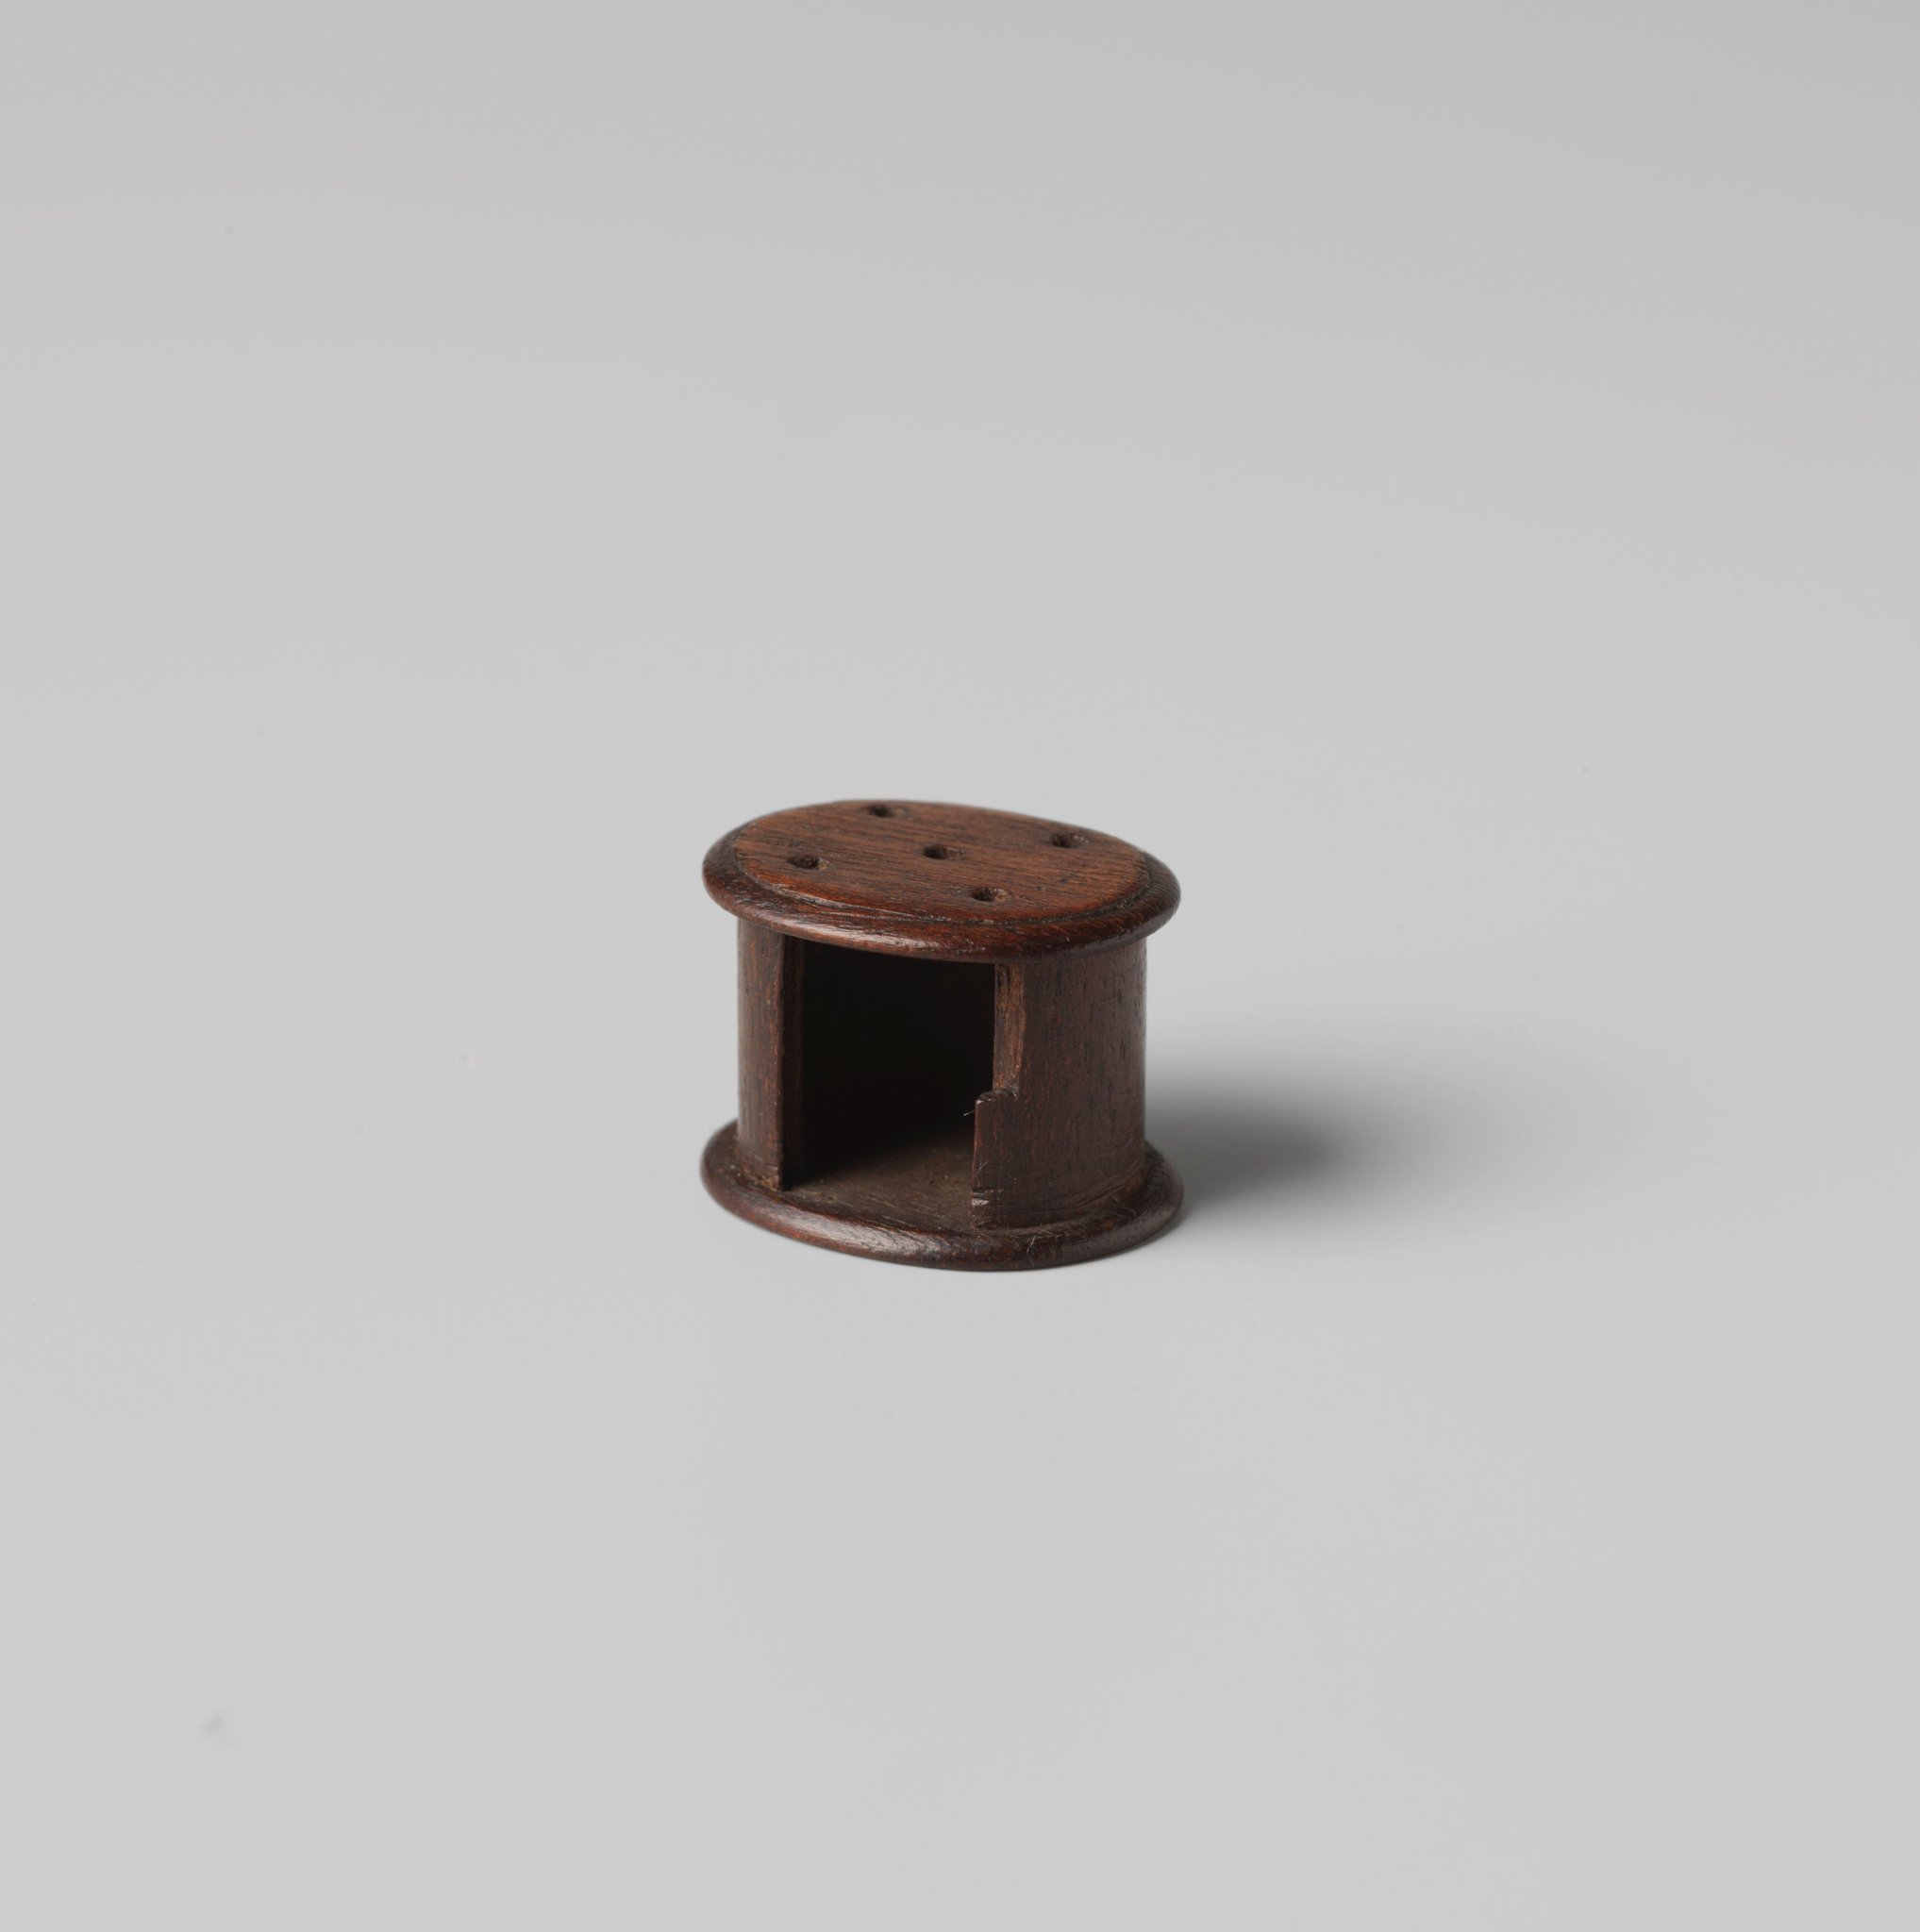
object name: voetstoof, stoof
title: Stoof, ovaal, met vijf gaten in de bovenzijde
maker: Anonymous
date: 1740-1760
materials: wood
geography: amsterdam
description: Stoof van mahoniehout, ovaal, met in de bovenzijde vijf gaten.